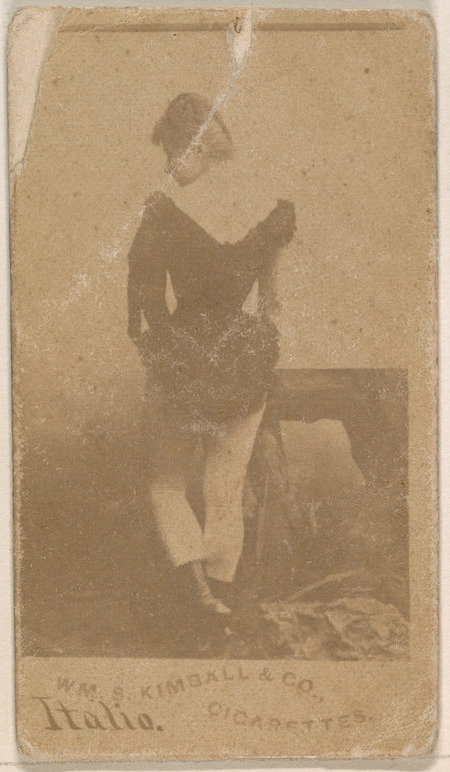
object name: photograph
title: Miss Italia, from the Actresses series (N203) issued by Wm. S. Kimball & Co.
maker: william s. kimball & company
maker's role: publisher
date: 1889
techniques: color lithograph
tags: portraits,women,actresses